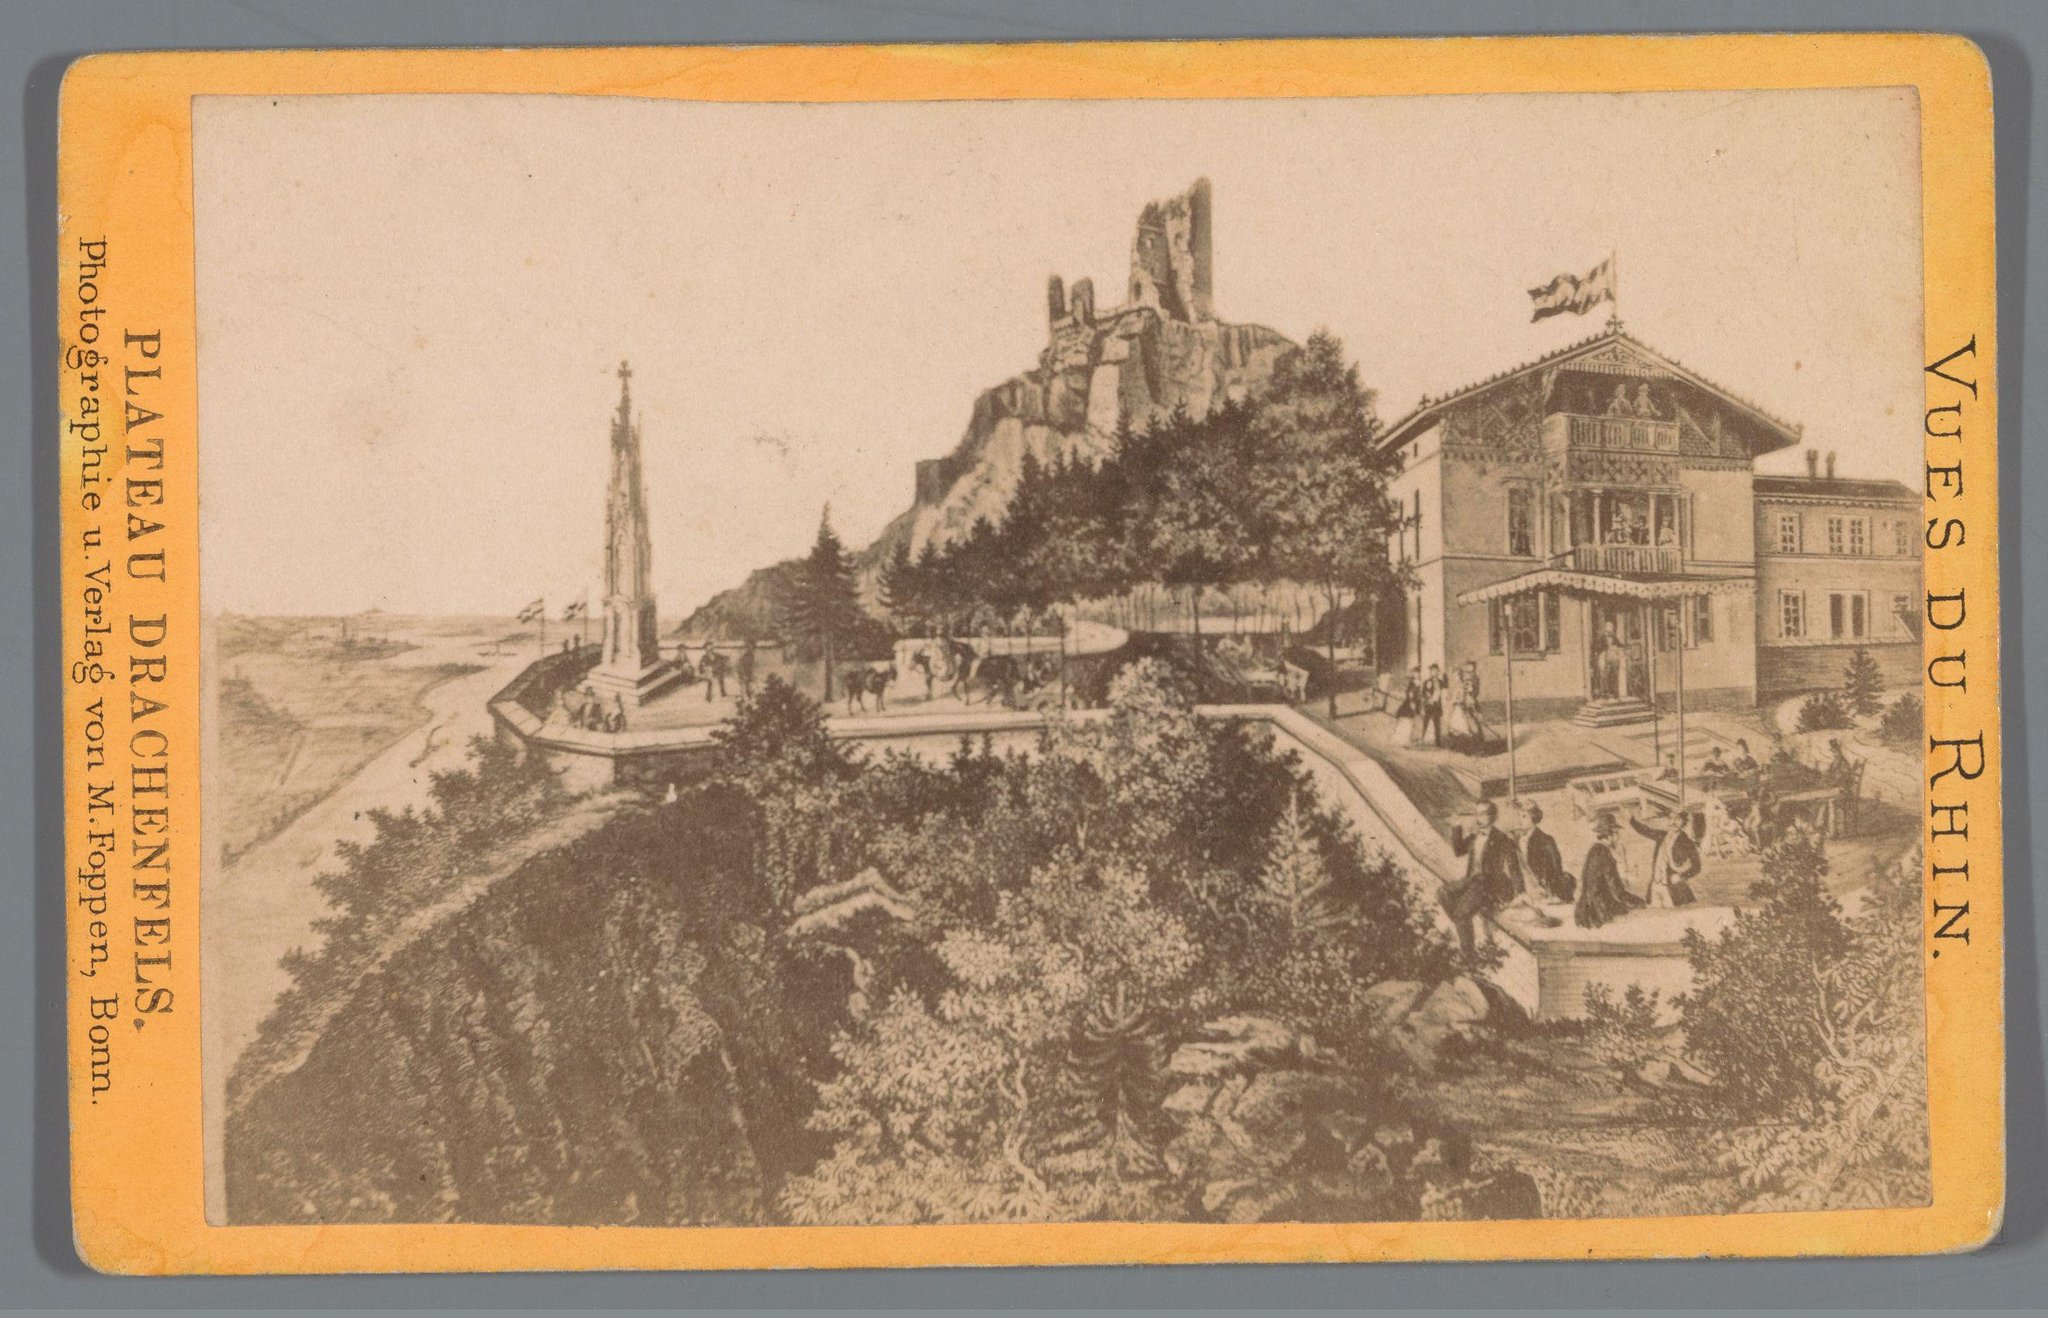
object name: reproduction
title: Vues du Rhin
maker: m. foppen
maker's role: fotograaf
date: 1855-1885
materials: cardboard, paper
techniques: albumen print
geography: bonn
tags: landscape with ruins